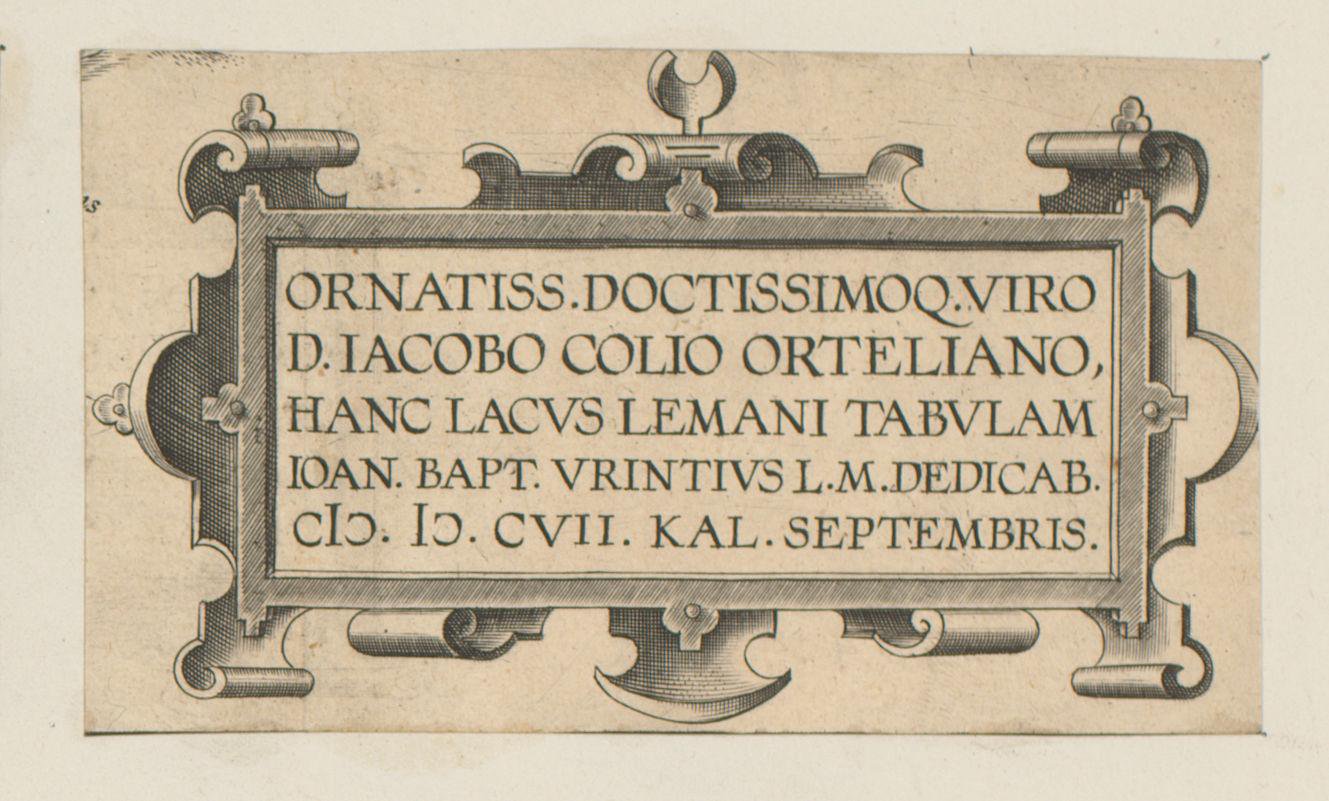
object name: print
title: Theatrum Orbis Terrarum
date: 1607-1608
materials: paper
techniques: engraving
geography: antwerp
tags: scrollwork, strapwork ~ ornament, ornament ~ cartouche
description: Rechthoekige cartouche met rolwerk. De cartouche is een fragment van een kaart van het meer van Genève. De prent maakt deel uit van een album.